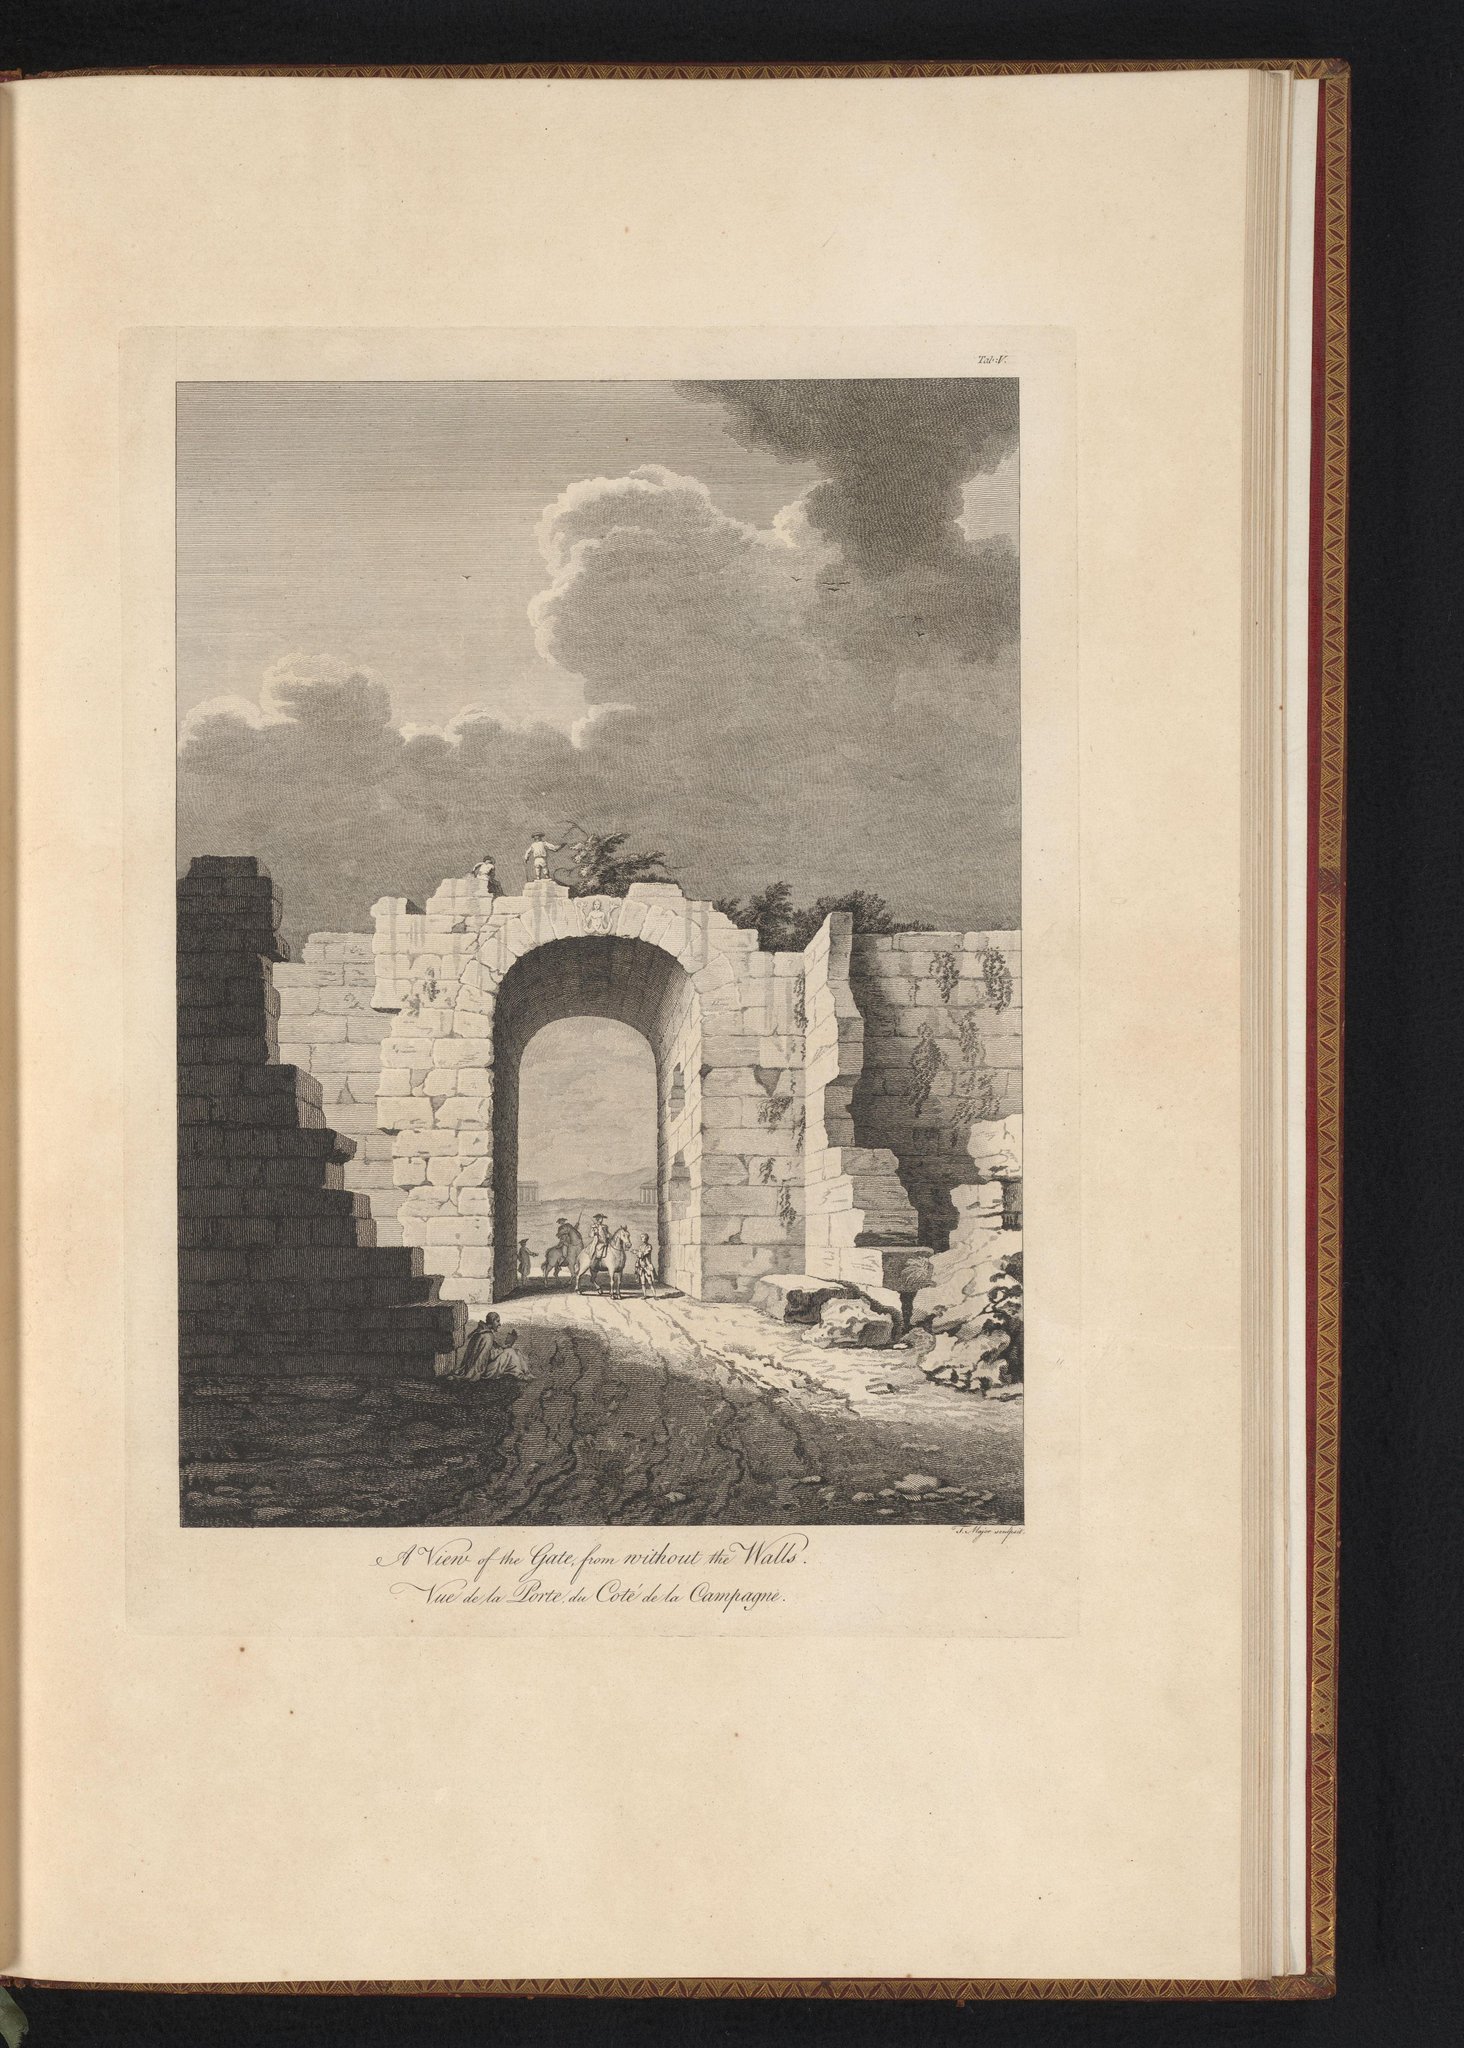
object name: print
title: A View of the Gate from without the Walls / Vue de la Porte, du Coté de la Campagne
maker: thomas major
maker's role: print maker, publisher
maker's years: 1714-1799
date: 1768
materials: paper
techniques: engraving, etching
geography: london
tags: landscape with ruins (+ city(-scape) with figures, staffage), city-gate, temple, shrine ~ greek religion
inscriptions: date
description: Deze prent is onderdeel van de reeks van 25 genummerde illustraties in deze uitgave.